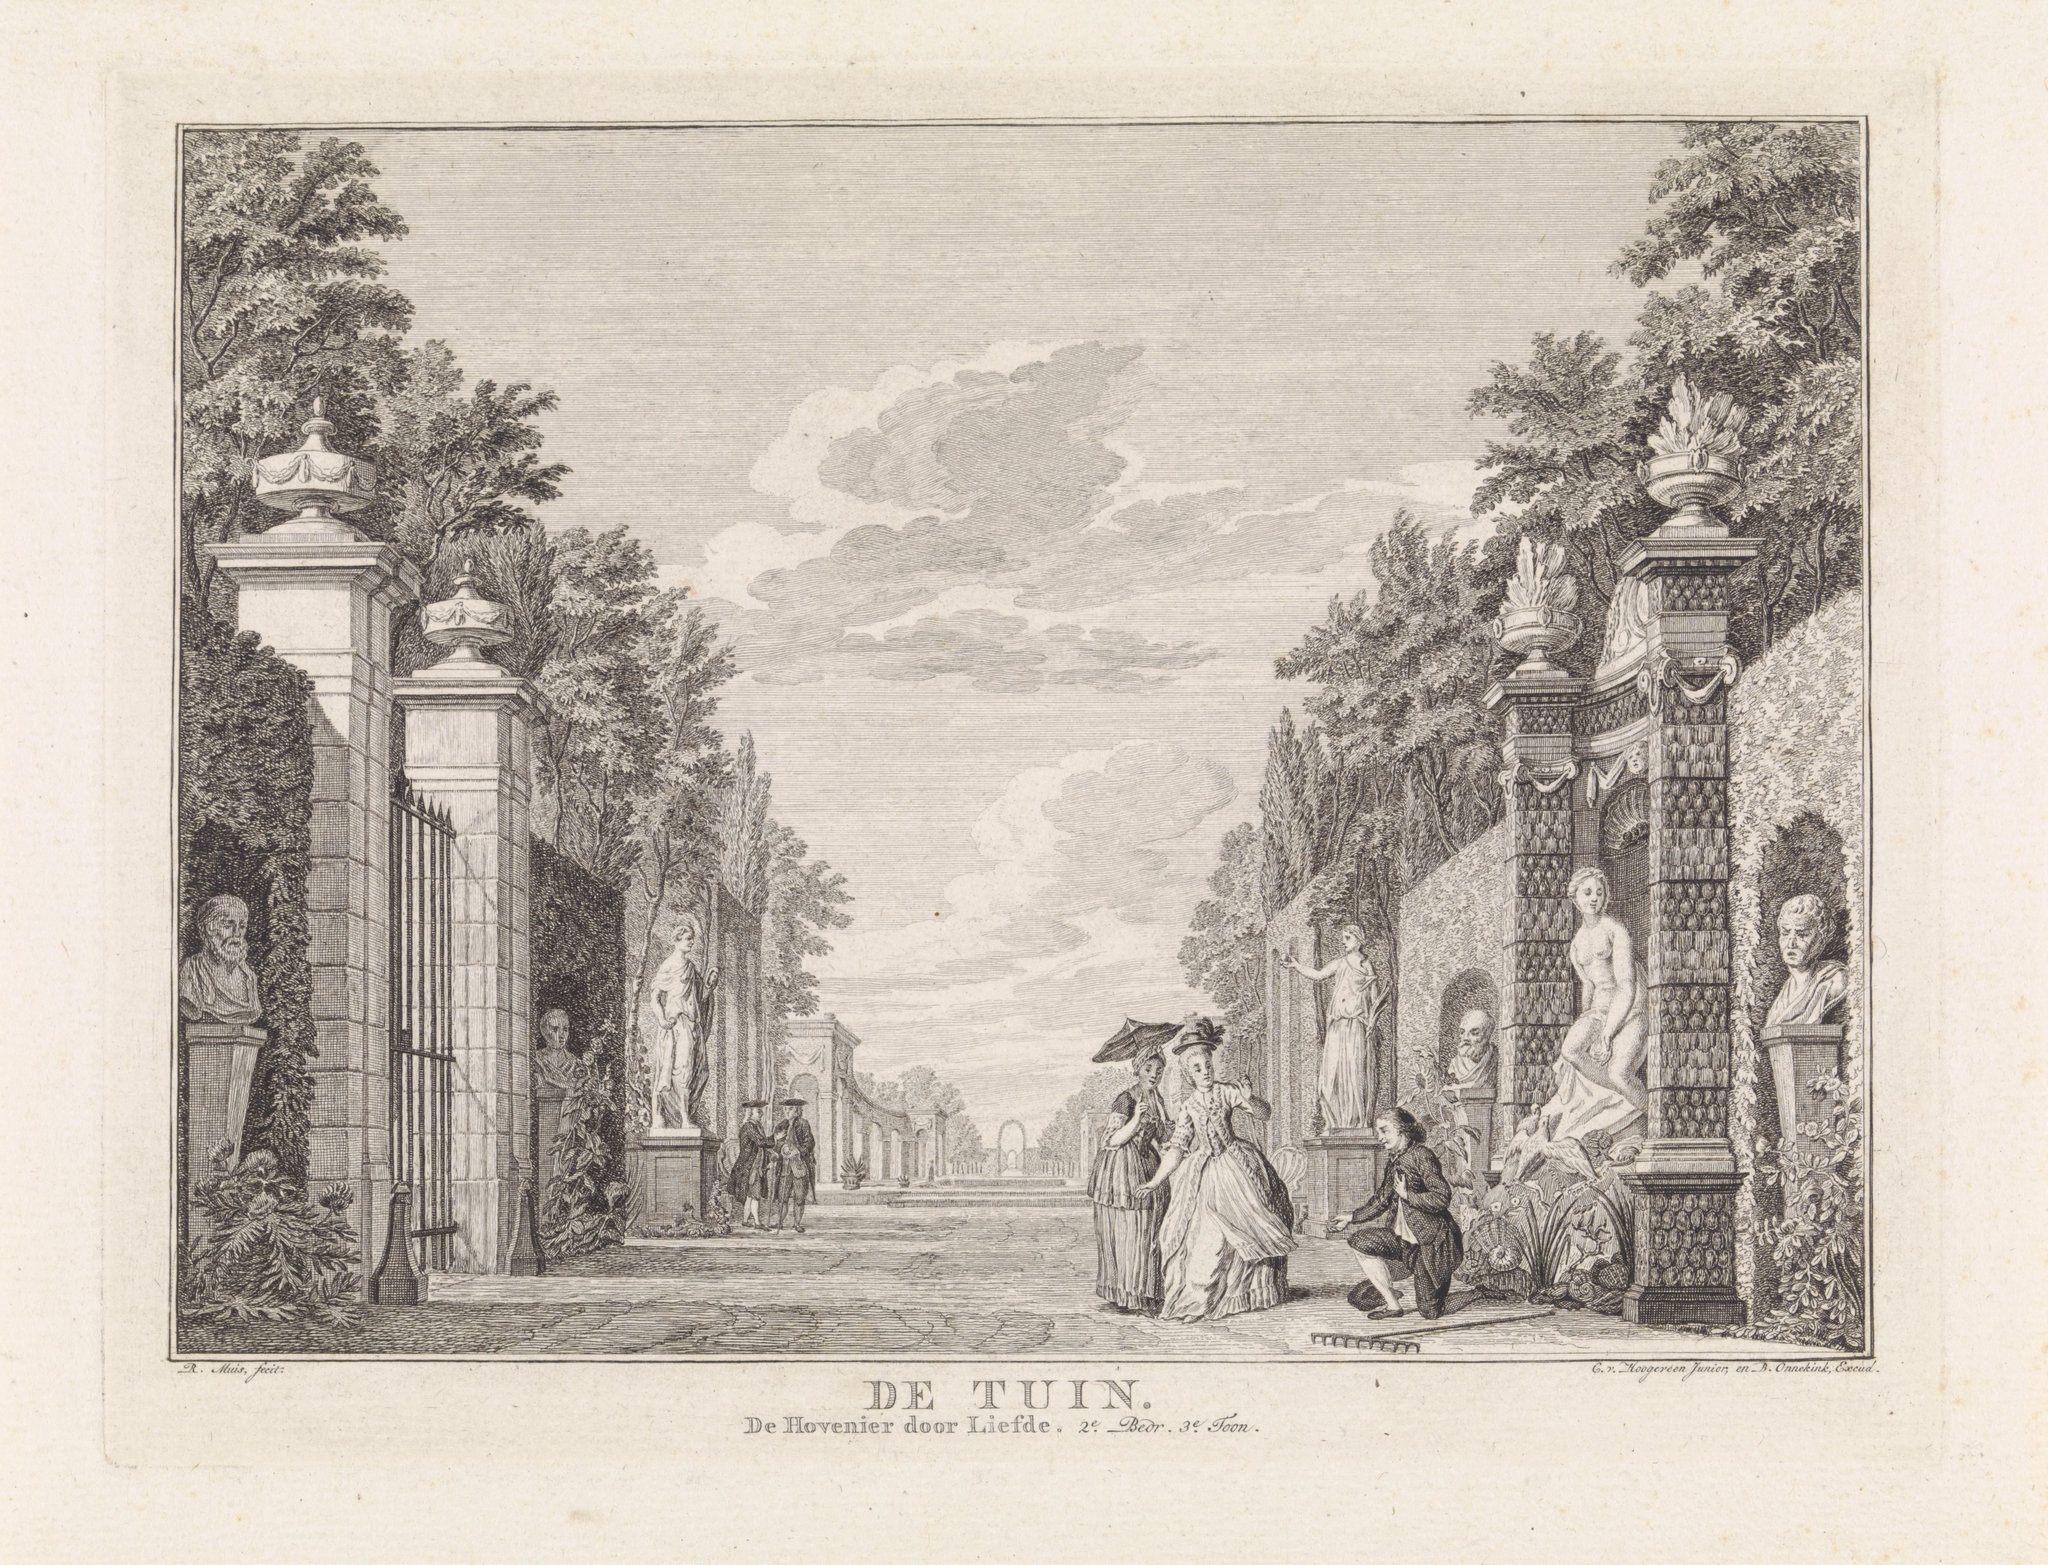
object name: print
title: De hovenier door liefde: de hovenier knielt voor twee vrouwen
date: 1752-1825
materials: paper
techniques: etching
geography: leiden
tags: french or architectonic garden; formal garden, gardening-tools, kneeling figure, comedy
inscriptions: collector's mark: Lugt 2228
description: In de laan van een formele tuin, knielt een hovenier voor twee welgestelde vrouwen. Op de grond naast de hovenier ligt een hark. De prent verbeeldt een toneelscène uit De hovenier door liefde, een blijspel van Florent Carton Dancourt.